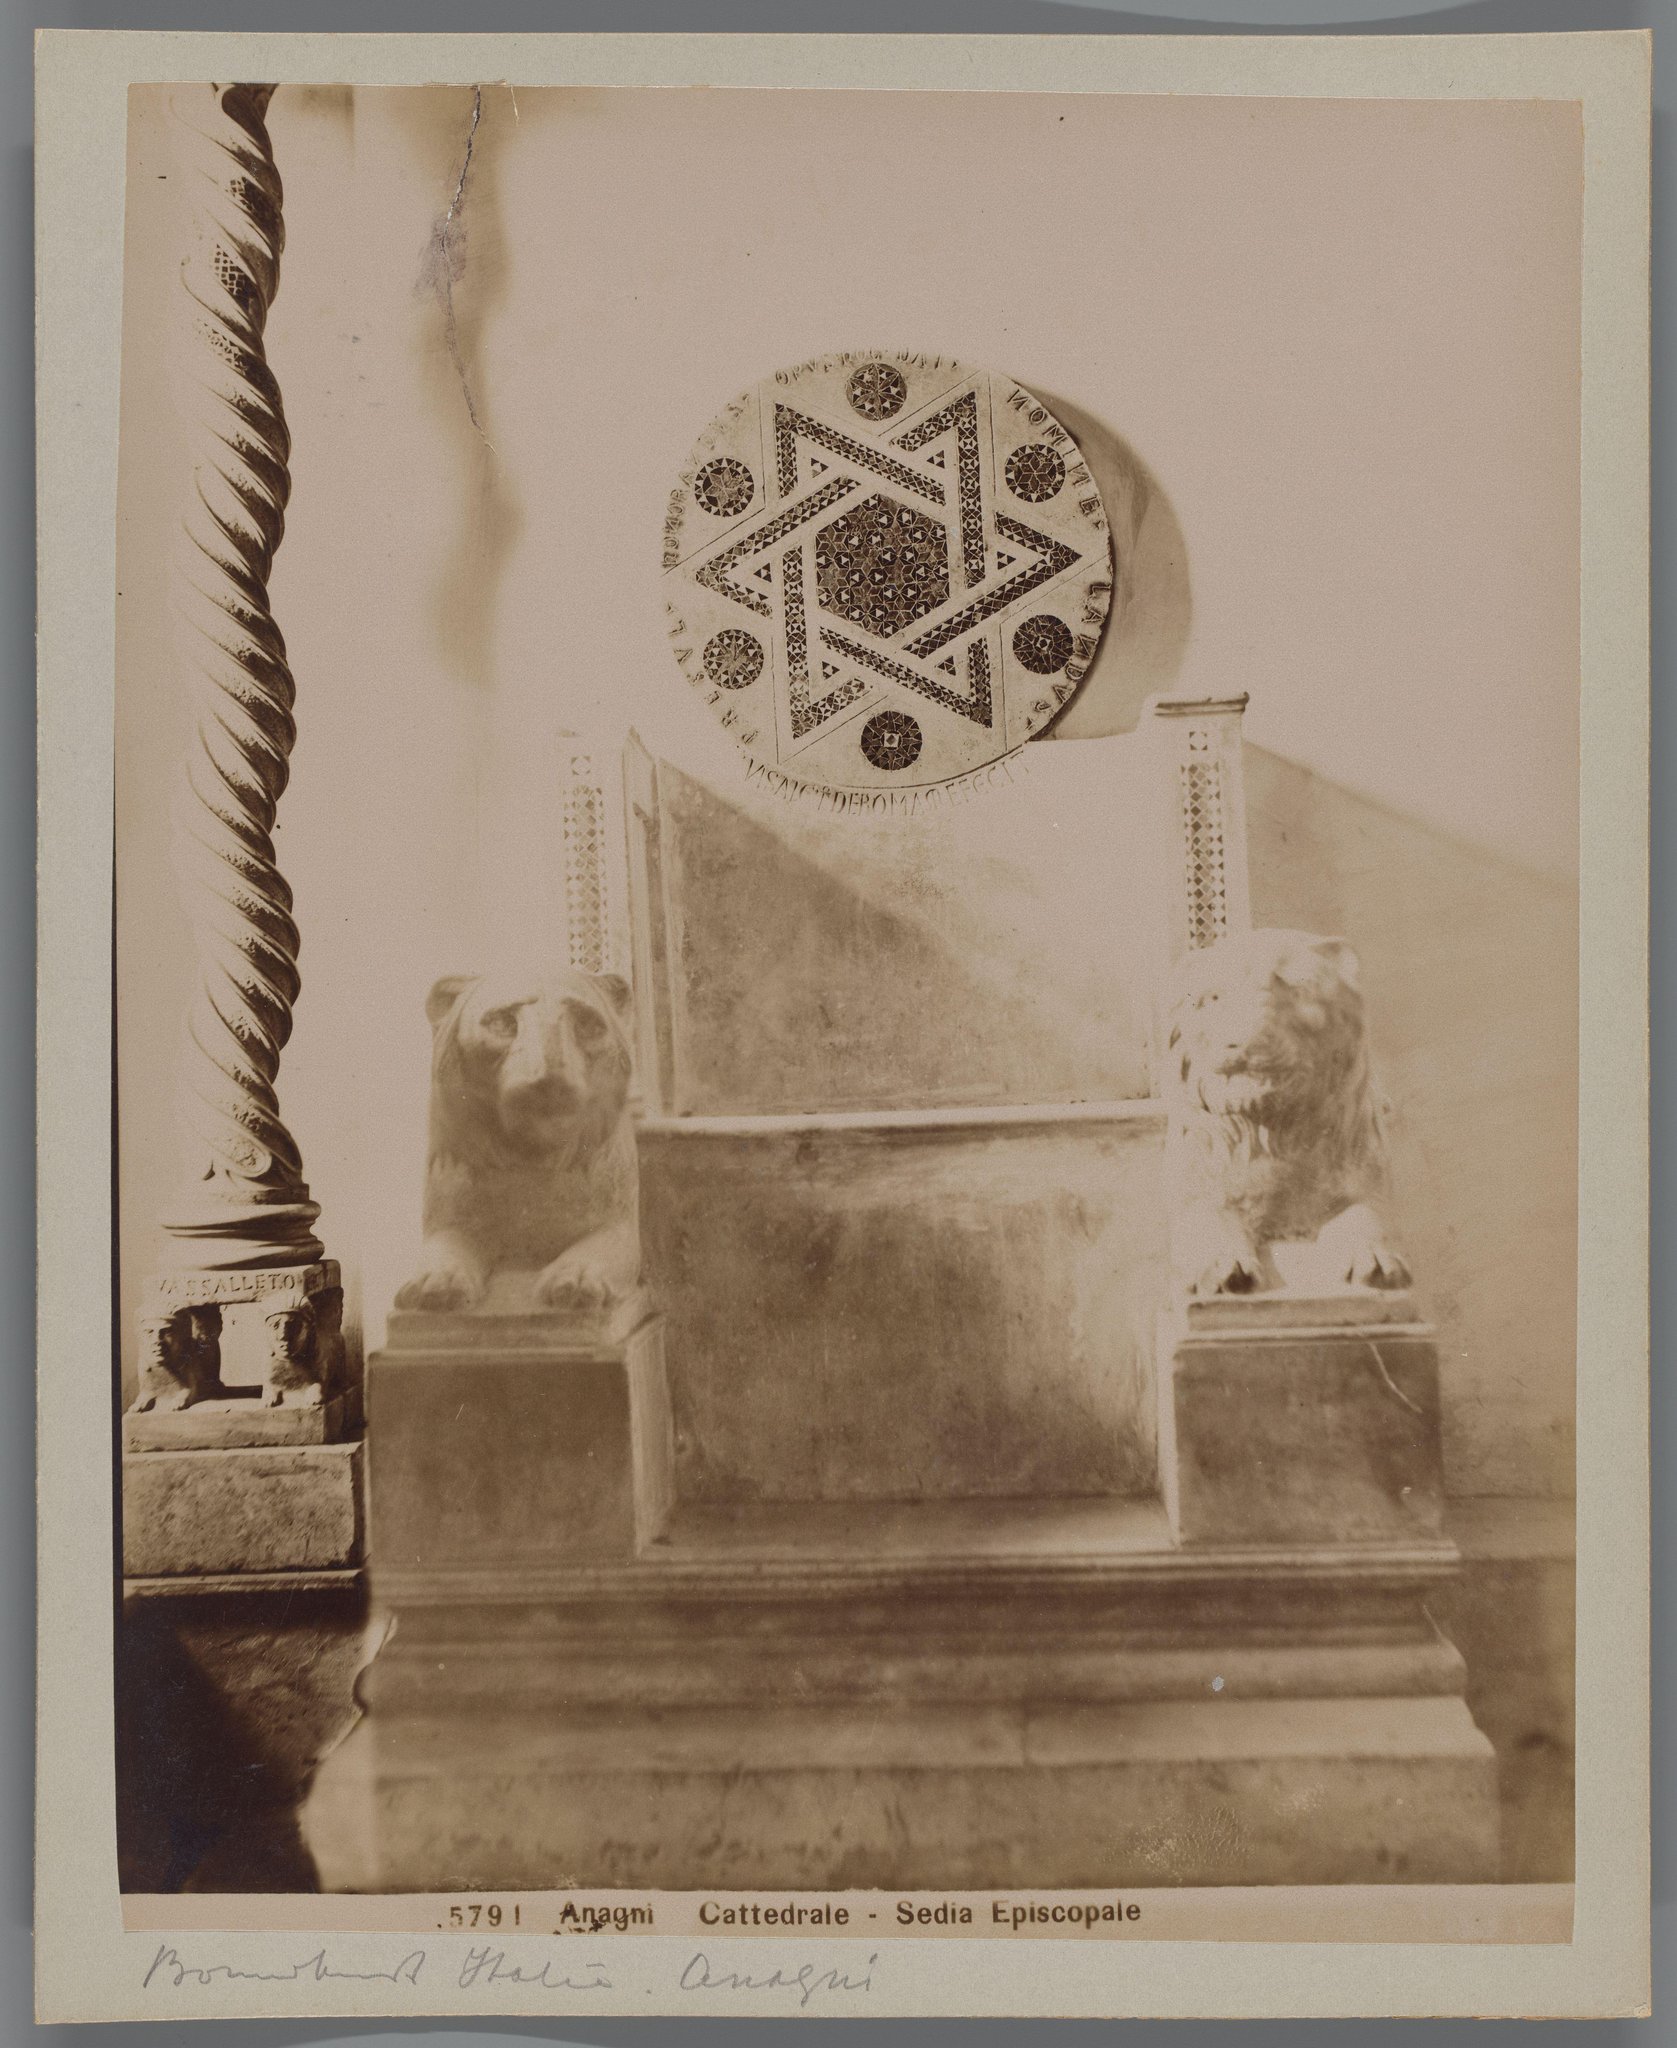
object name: photograph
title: Italië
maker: Anonymous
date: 1880-1910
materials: photographic support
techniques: albumen print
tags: italy